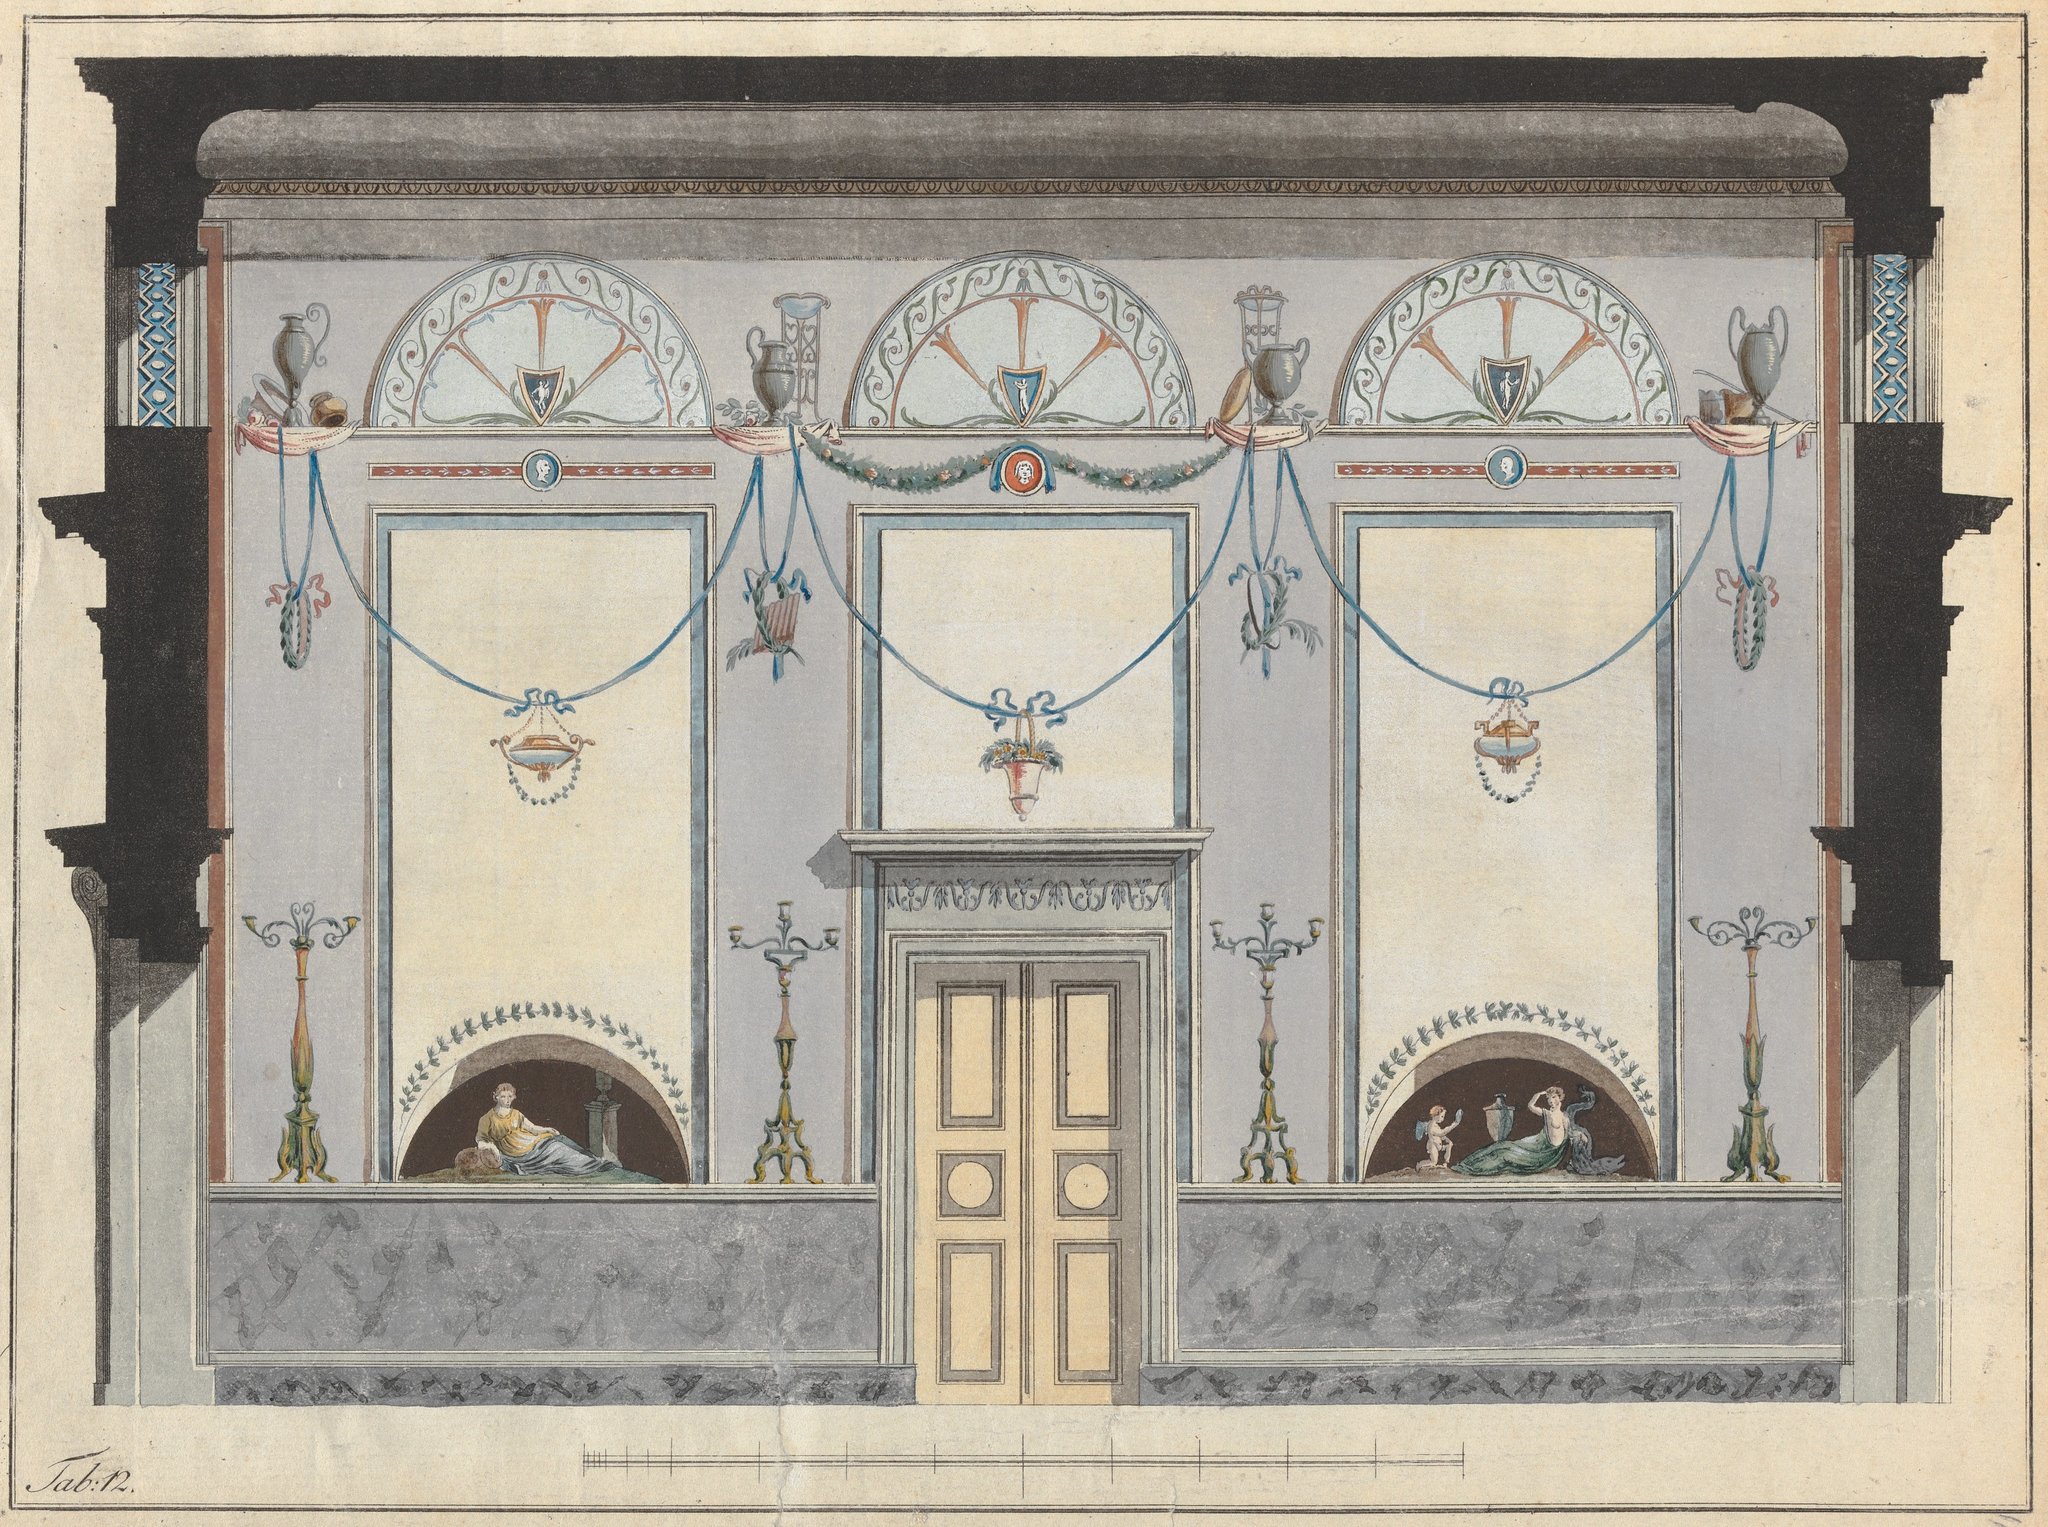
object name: book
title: Magazin für Freunde des Guten Geschmacks der Bildenden und Mechanischen Künste, Manufakturen und Gewerbe, Band 2, No. 4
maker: friedrich august leo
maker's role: publisher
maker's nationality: german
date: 1796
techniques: etching, hand coloring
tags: architecture,doors